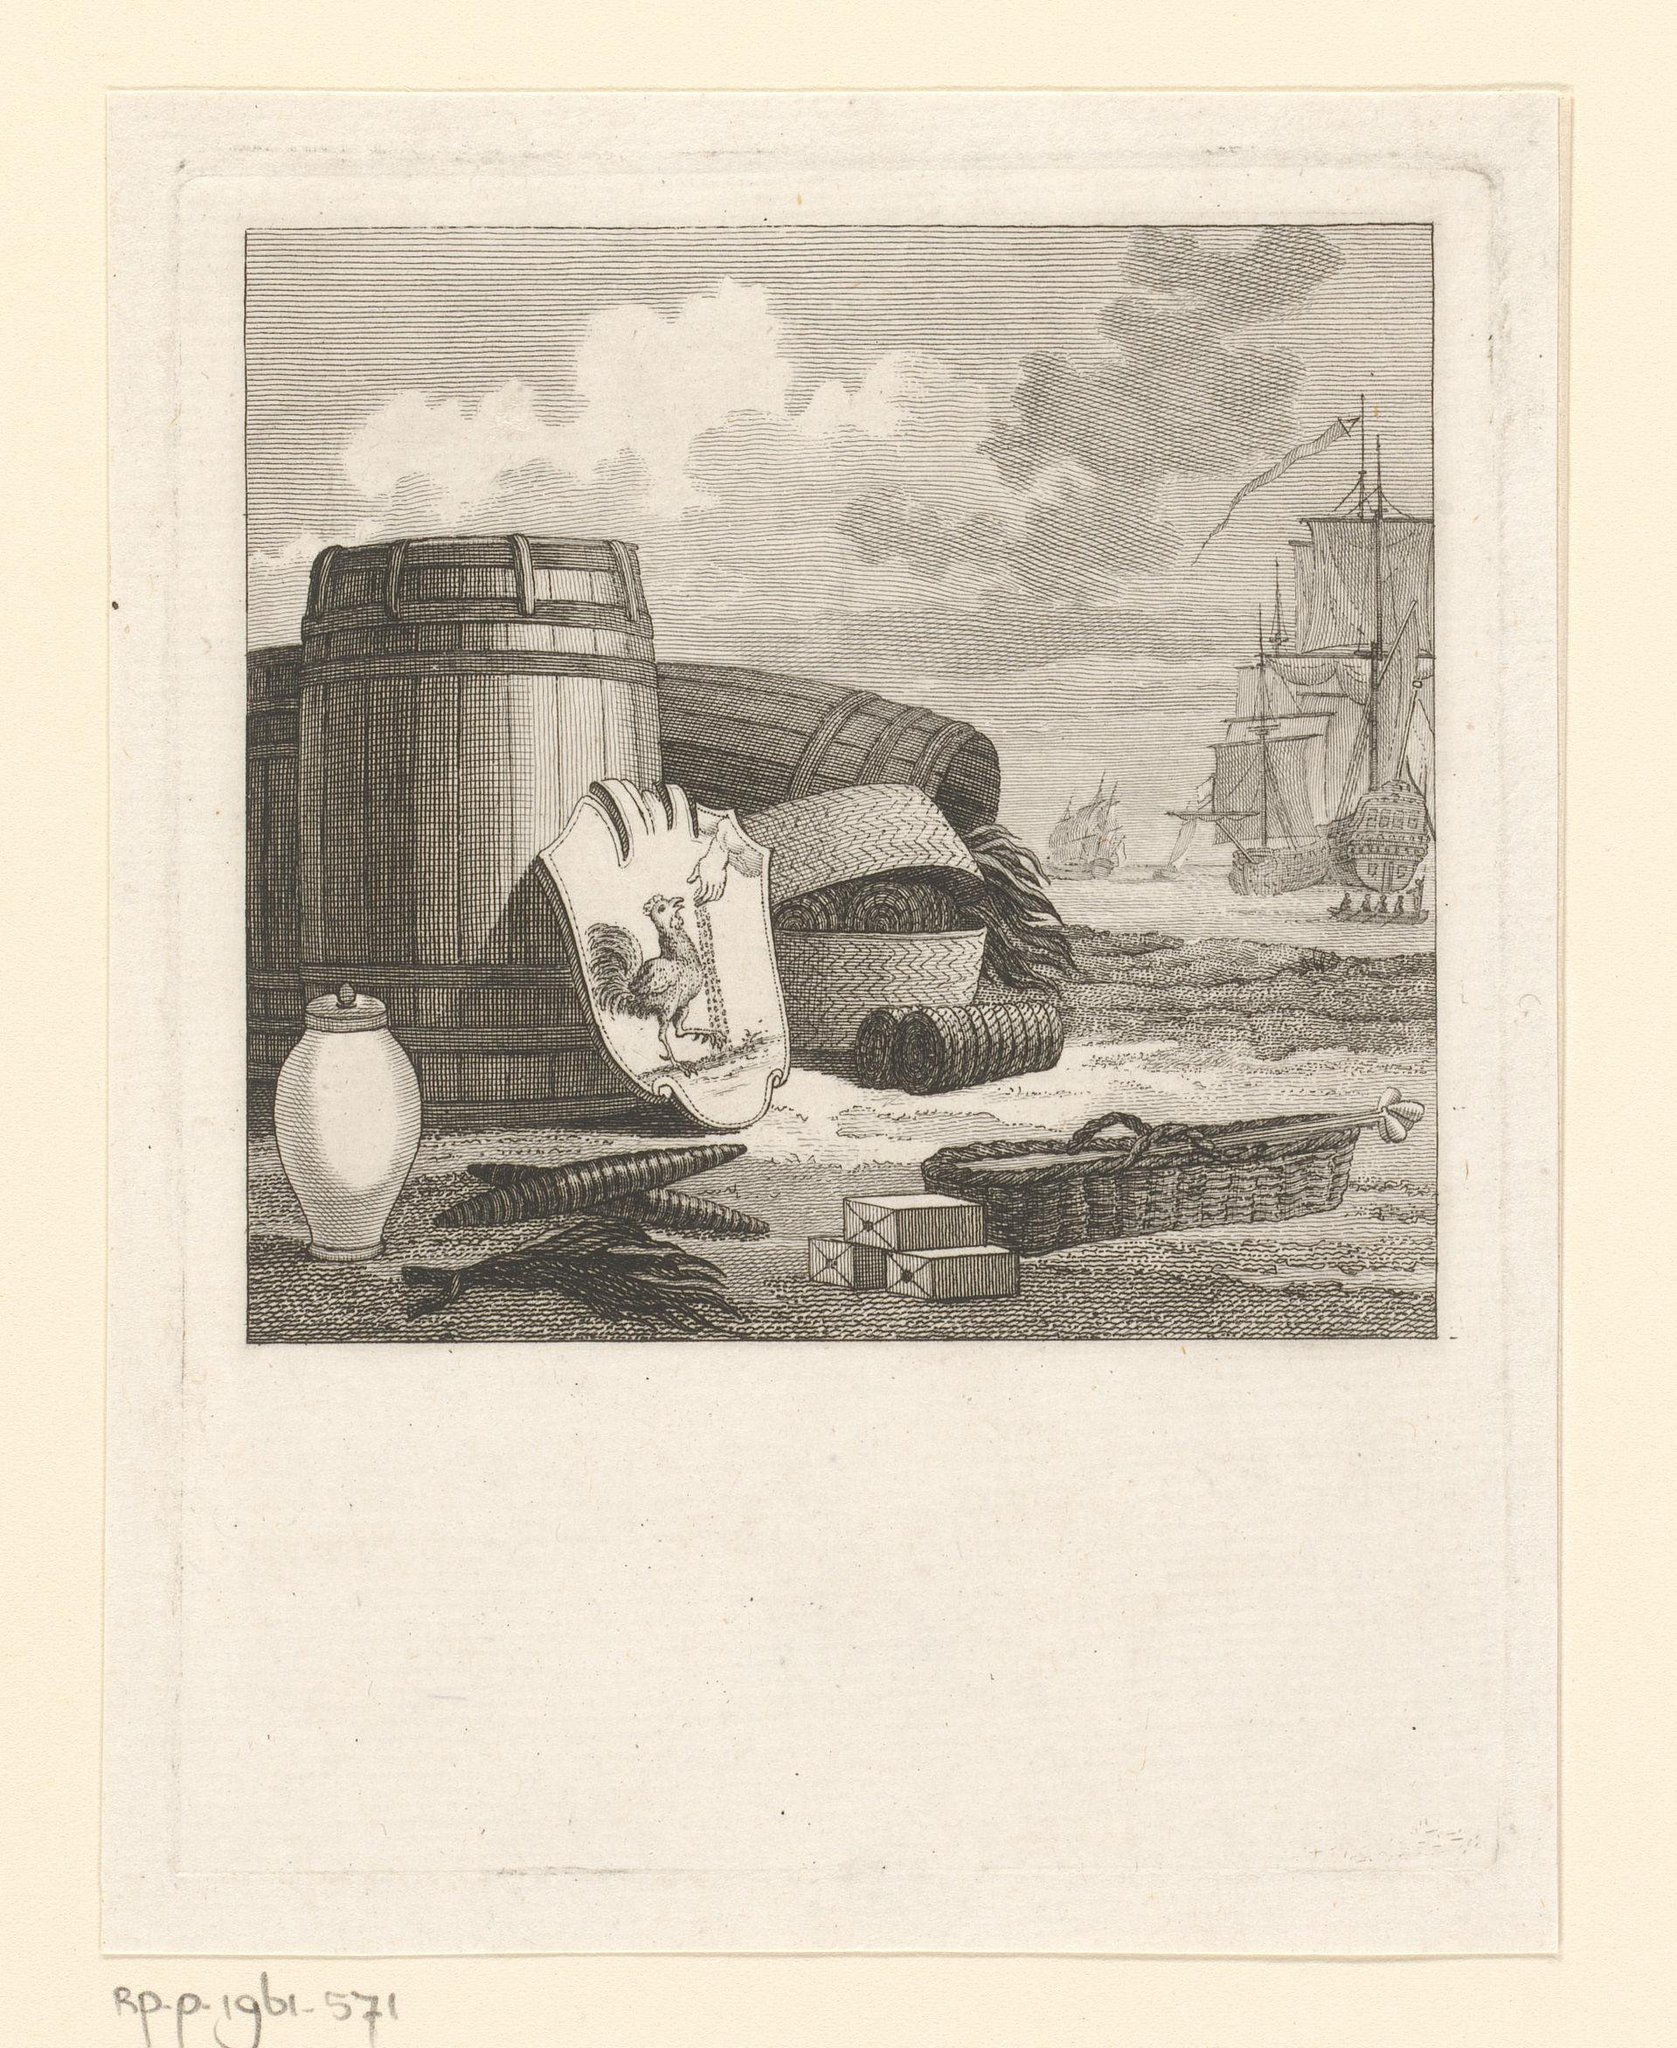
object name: print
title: Kustgezicht met manden, vaten en wapenschild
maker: Anonymous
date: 1700-1799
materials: paper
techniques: engraving, etching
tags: coat of arms (as symbol of the state, etc.), wooden container: barrel, cask, bucket, sailing-ship, sailing-boat, container made of plant material other than wood: basket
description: Op de voorgrond koopwaar, pakketten en een urn, met daarachter manden en vaten. Tegen de vaten leunt een wapenschild met daarop een hand die zaden voor een haan uitstrooit. Op de achtergrond zeilschepen.